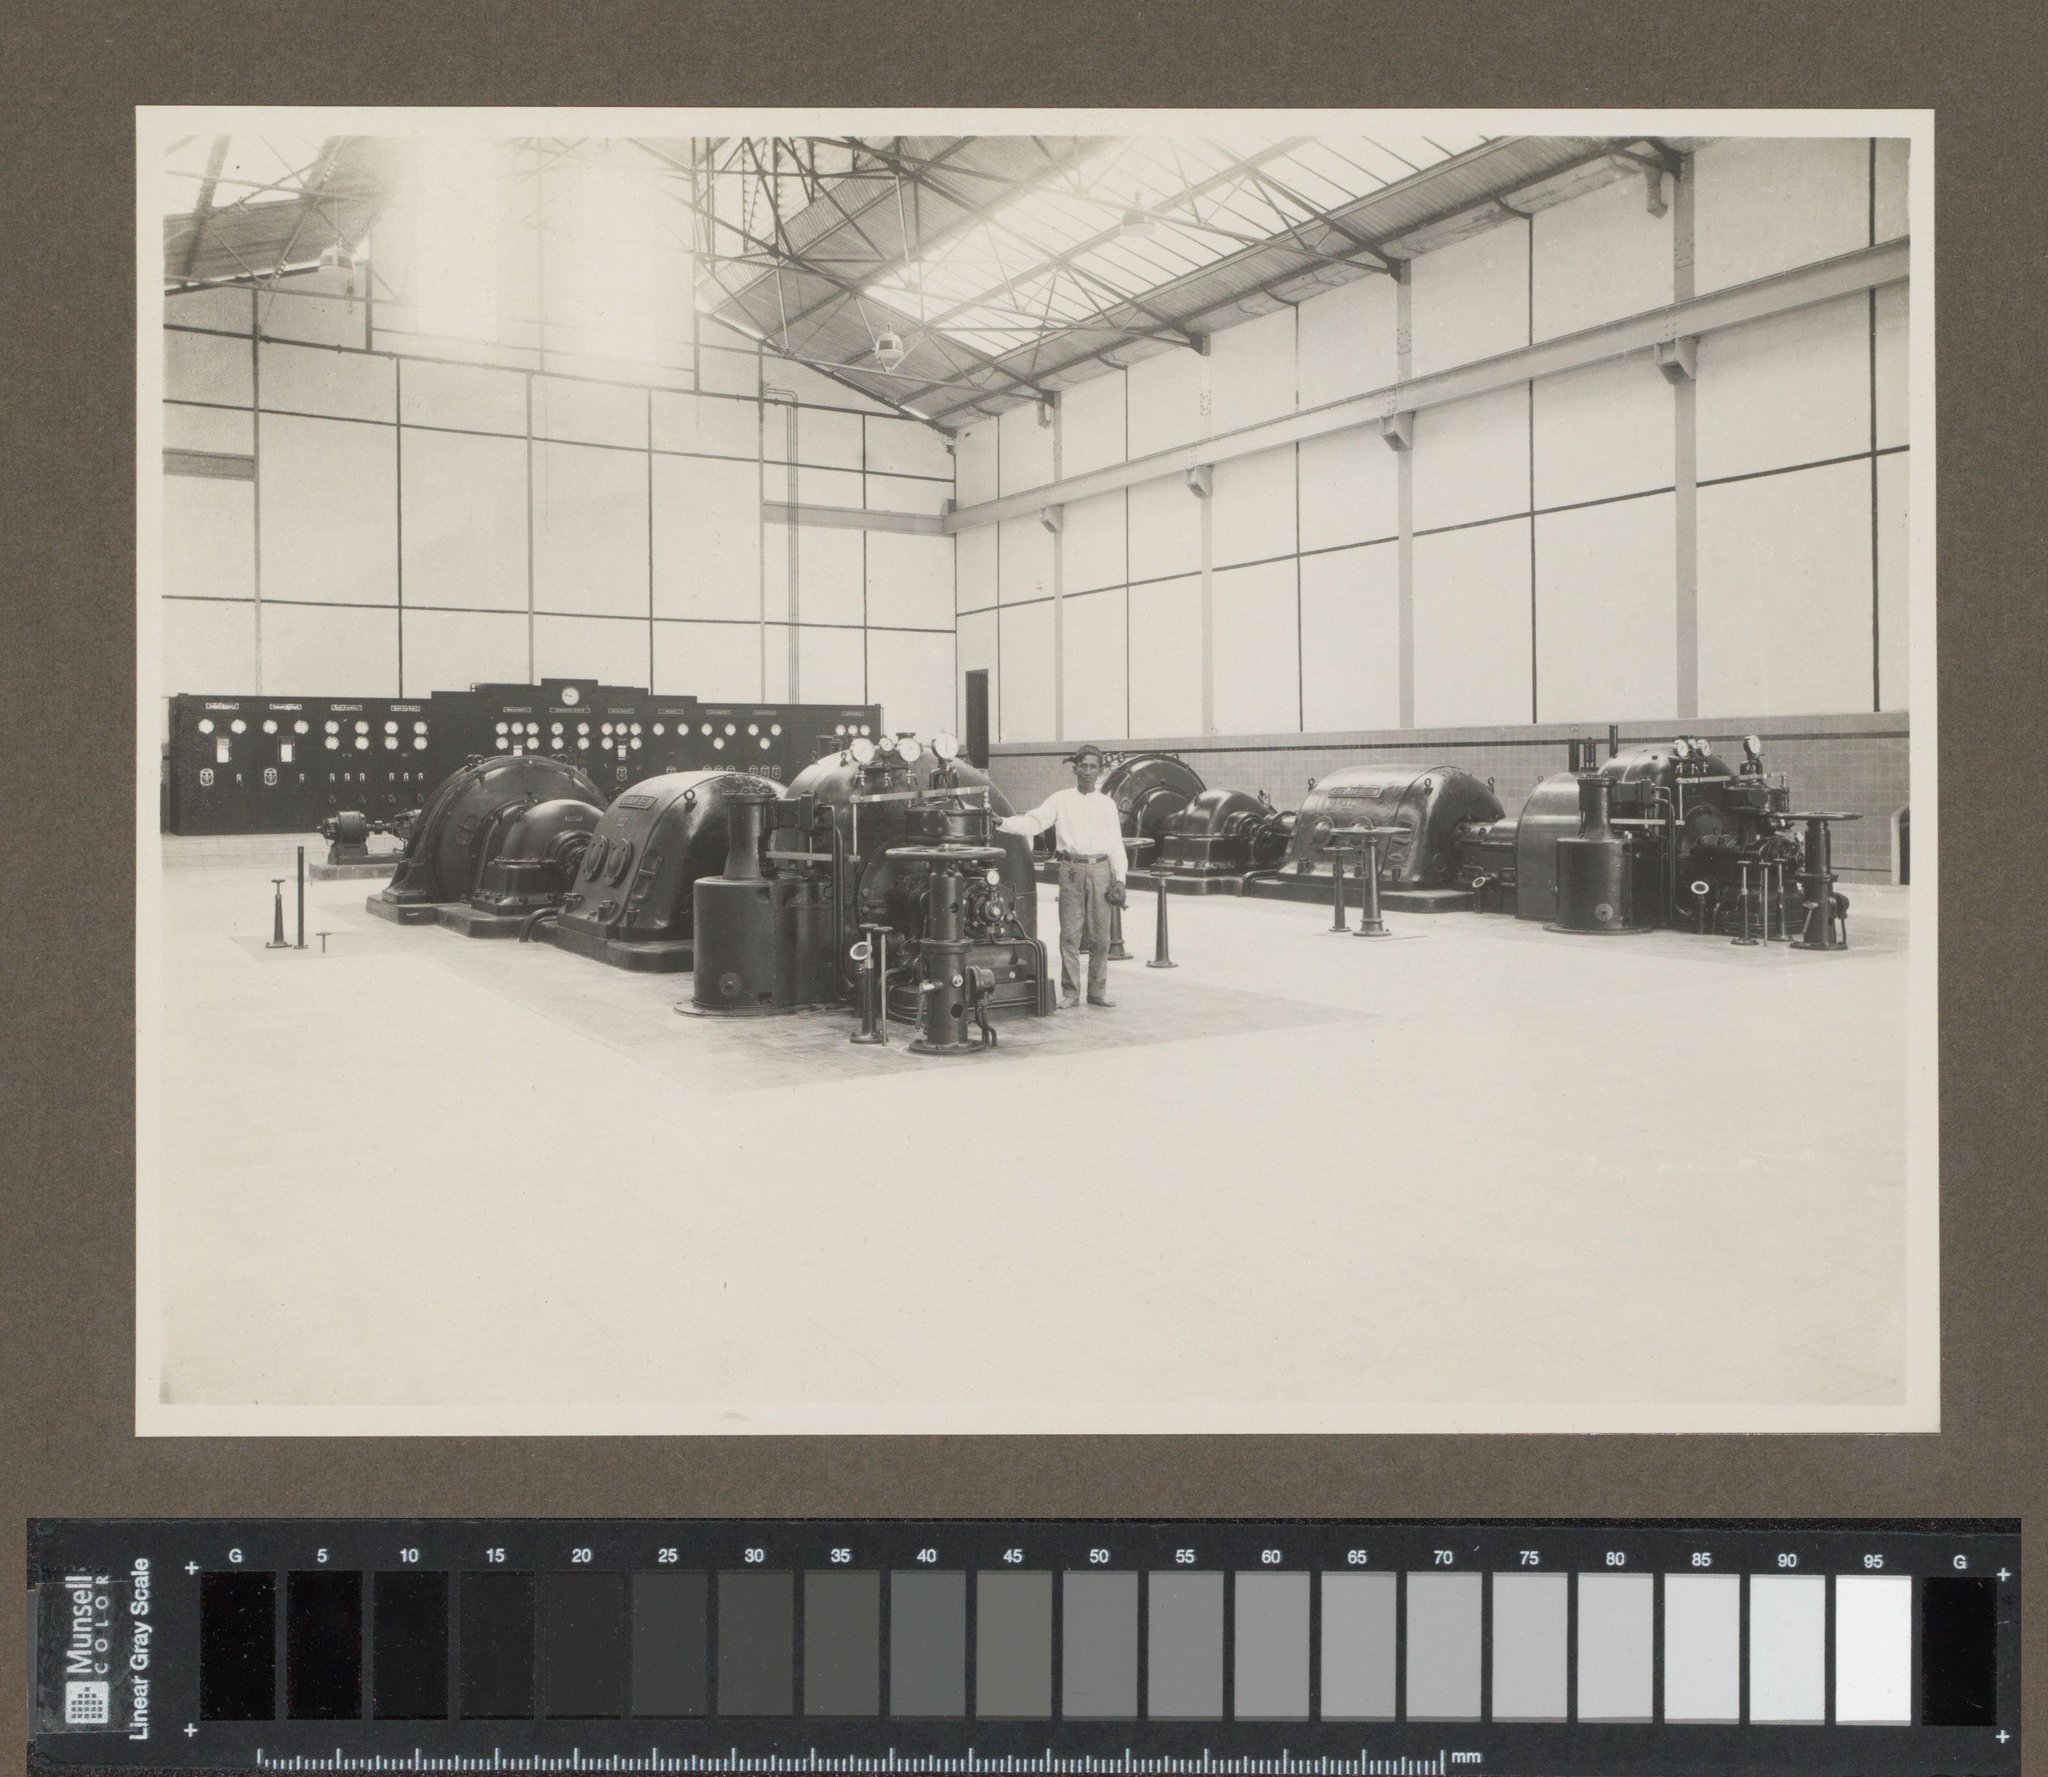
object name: photograph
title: Goenoengsari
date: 1904-1931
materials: photographic support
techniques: gelatin silver print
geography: surabaya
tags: colonial system, trade-company, (non-fruit) products of plants or trees: sugarcane, interior of industrial structures (regardless of the materials processed or the products made, surabaya, java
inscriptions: inscription: ‘Goenoengsari.’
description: Turbinehal in de suikerfabriek van de HVA te Goenoengsari. Foto in het het fotoalbum aangeboden aan A. van der Eyk namens de chefs en het personeel van de Handelsvereniging Amsterdam (HVA) te Soerabaja bij zijn vertrek van Java in april 1931.